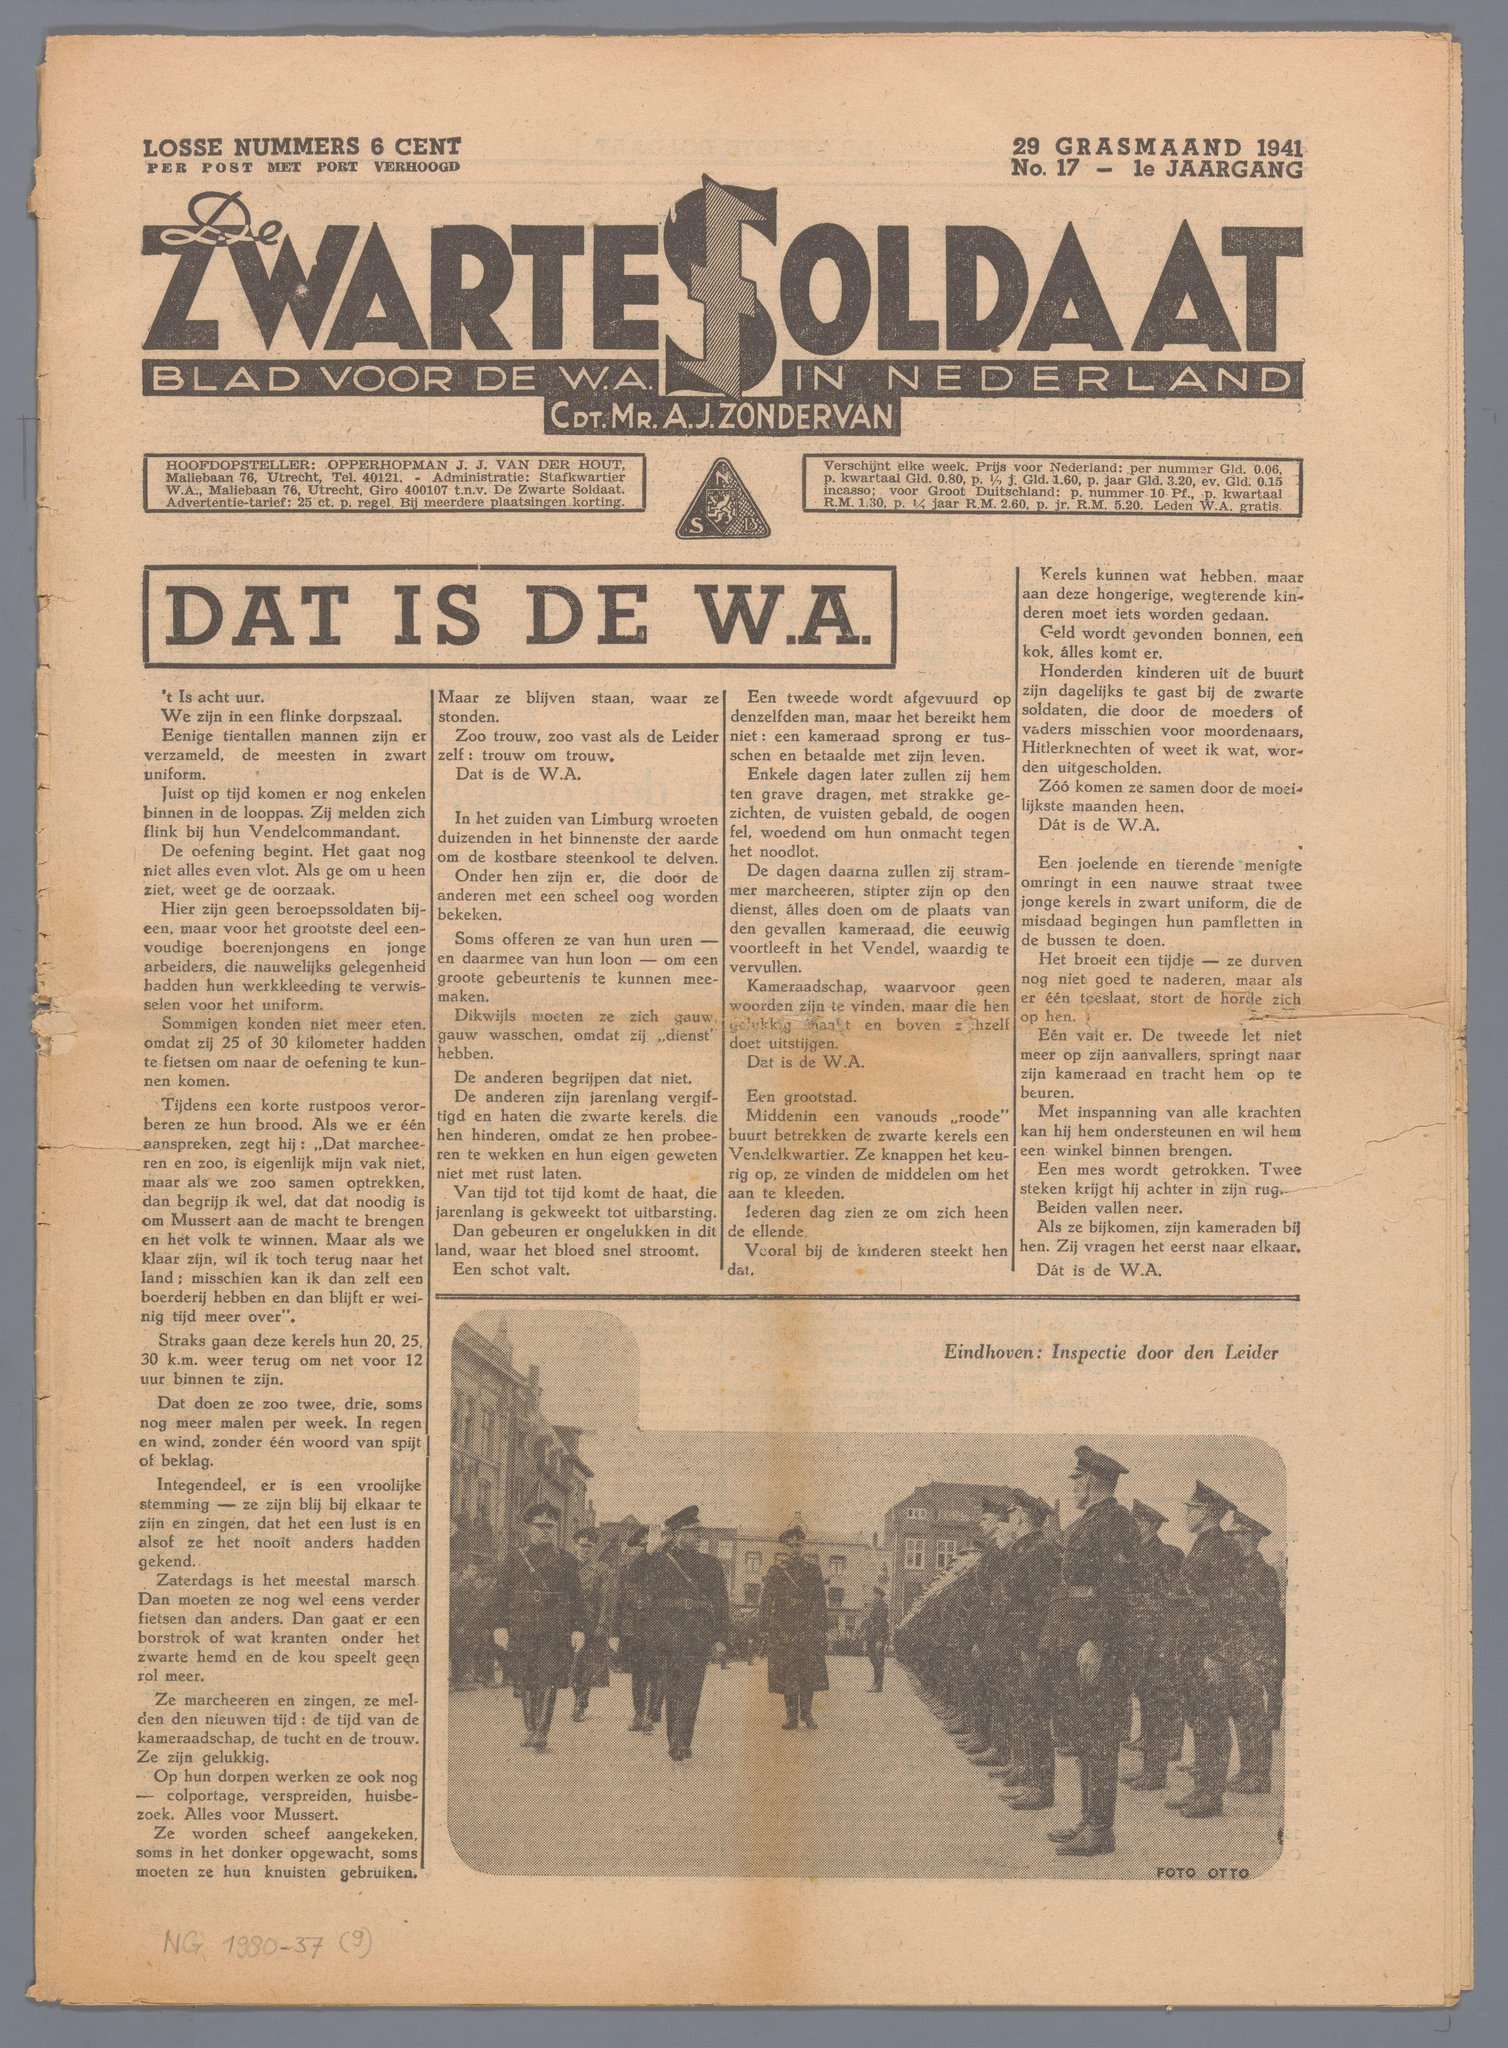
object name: newspaper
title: De Zwarte Soldaat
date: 1941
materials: paper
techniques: printing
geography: utrecht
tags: tweede wereldoorlog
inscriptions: date